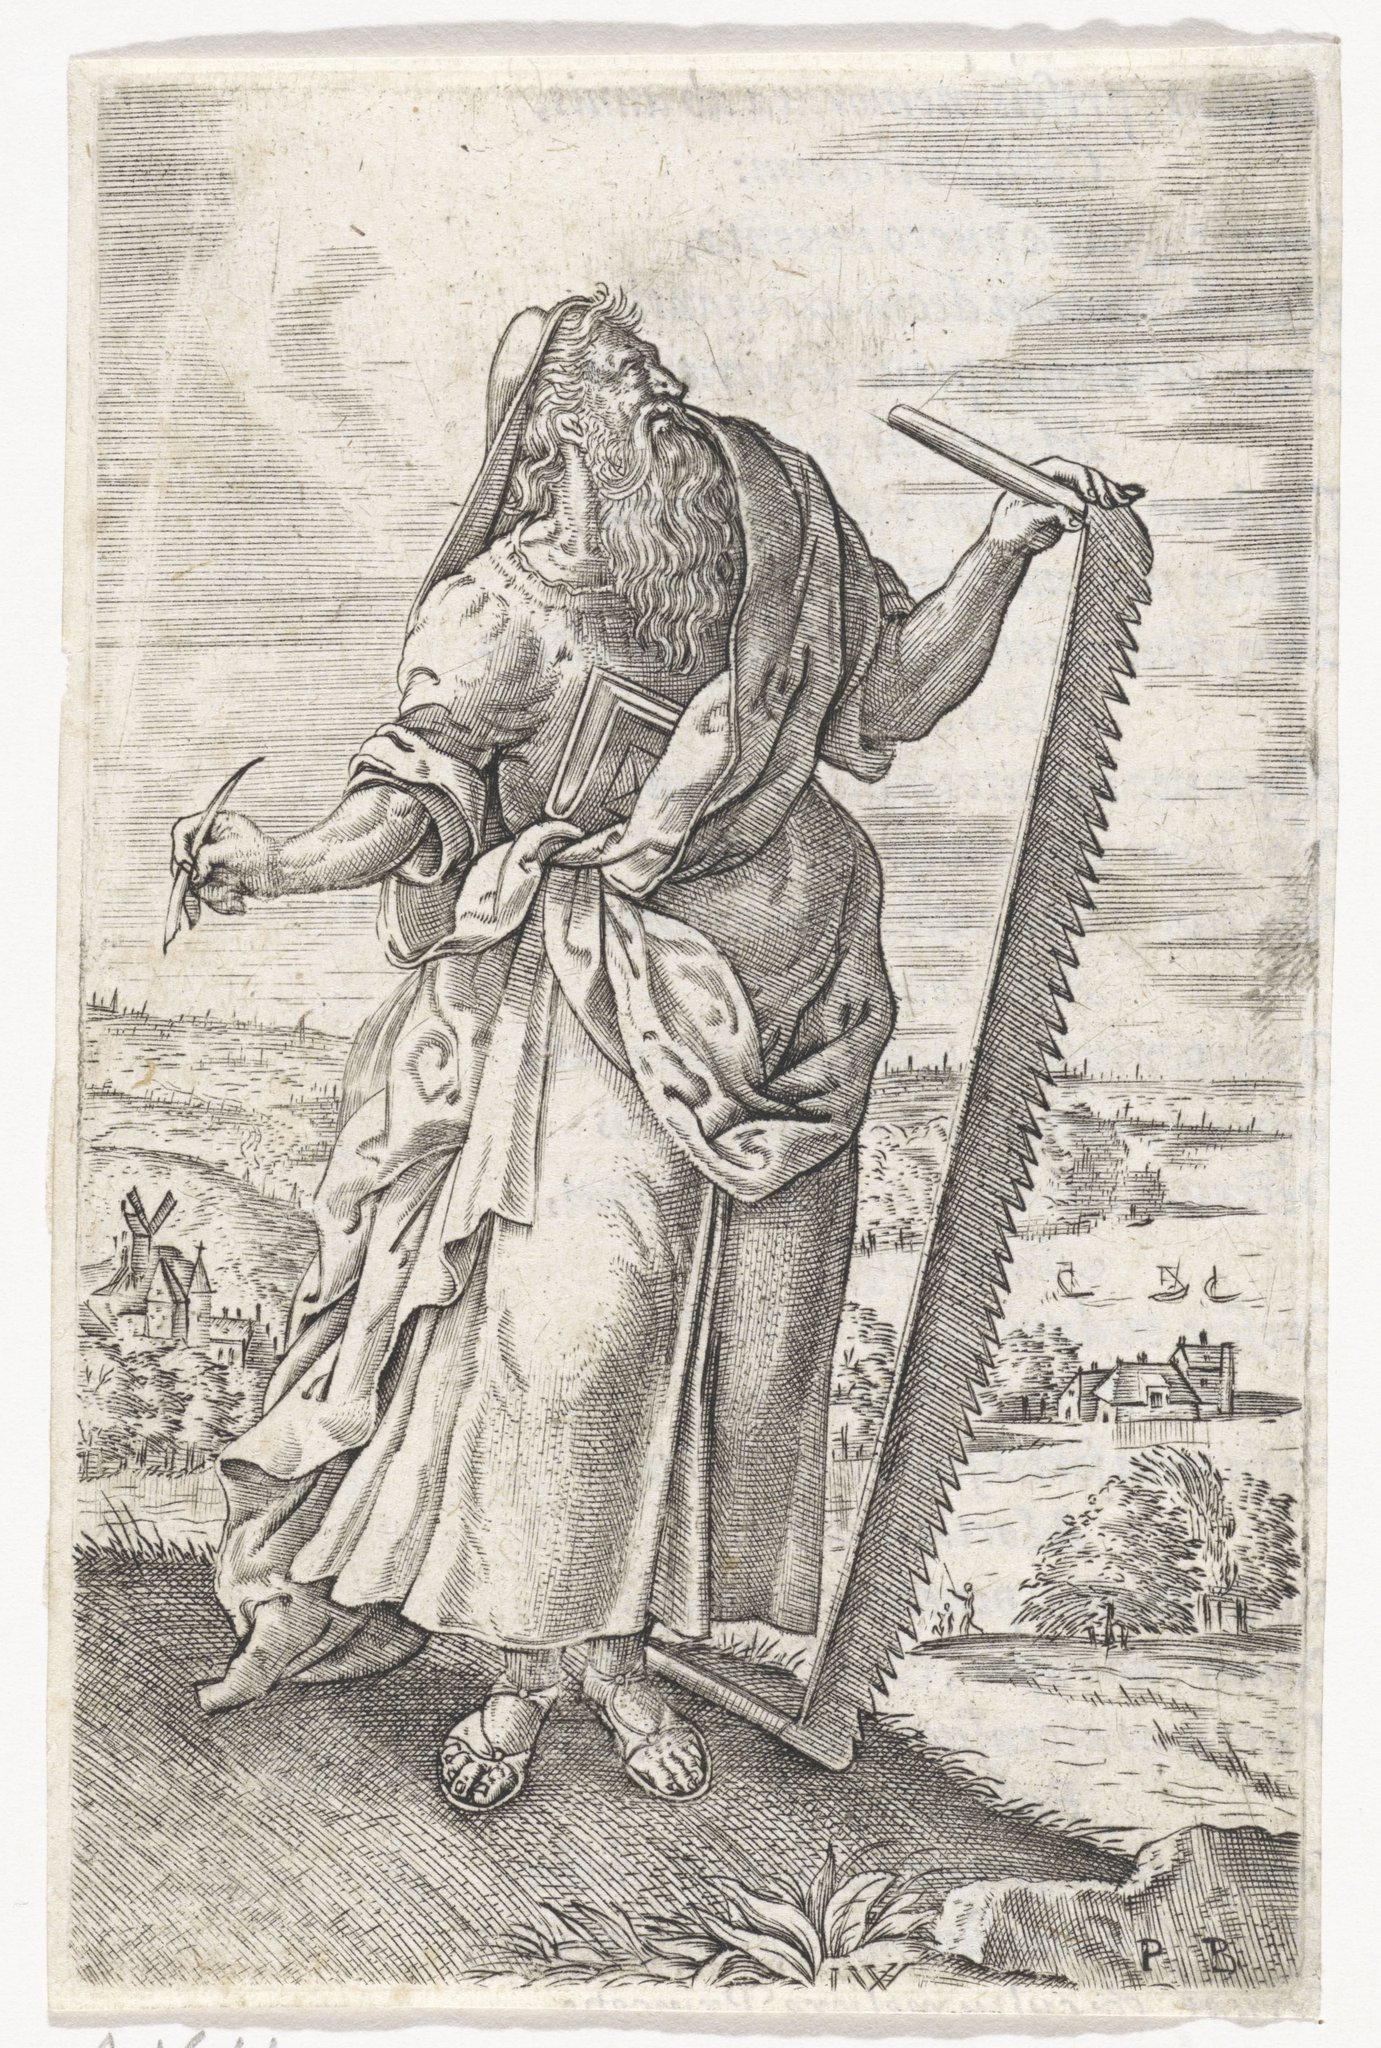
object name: book illustration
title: Landschap met de profeet Jesaja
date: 1571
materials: paper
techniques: engraving, letterpress printing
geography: antwerp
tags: martyrdom of isaiah: by order of king manasseh, isaiah is sawn in two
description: Prent gebruikt in: Arias-Montano, Benedictus. Humanae Salutis Monumenta, p. 26. Antwerpen: Christoffel Plantijn, 1571.